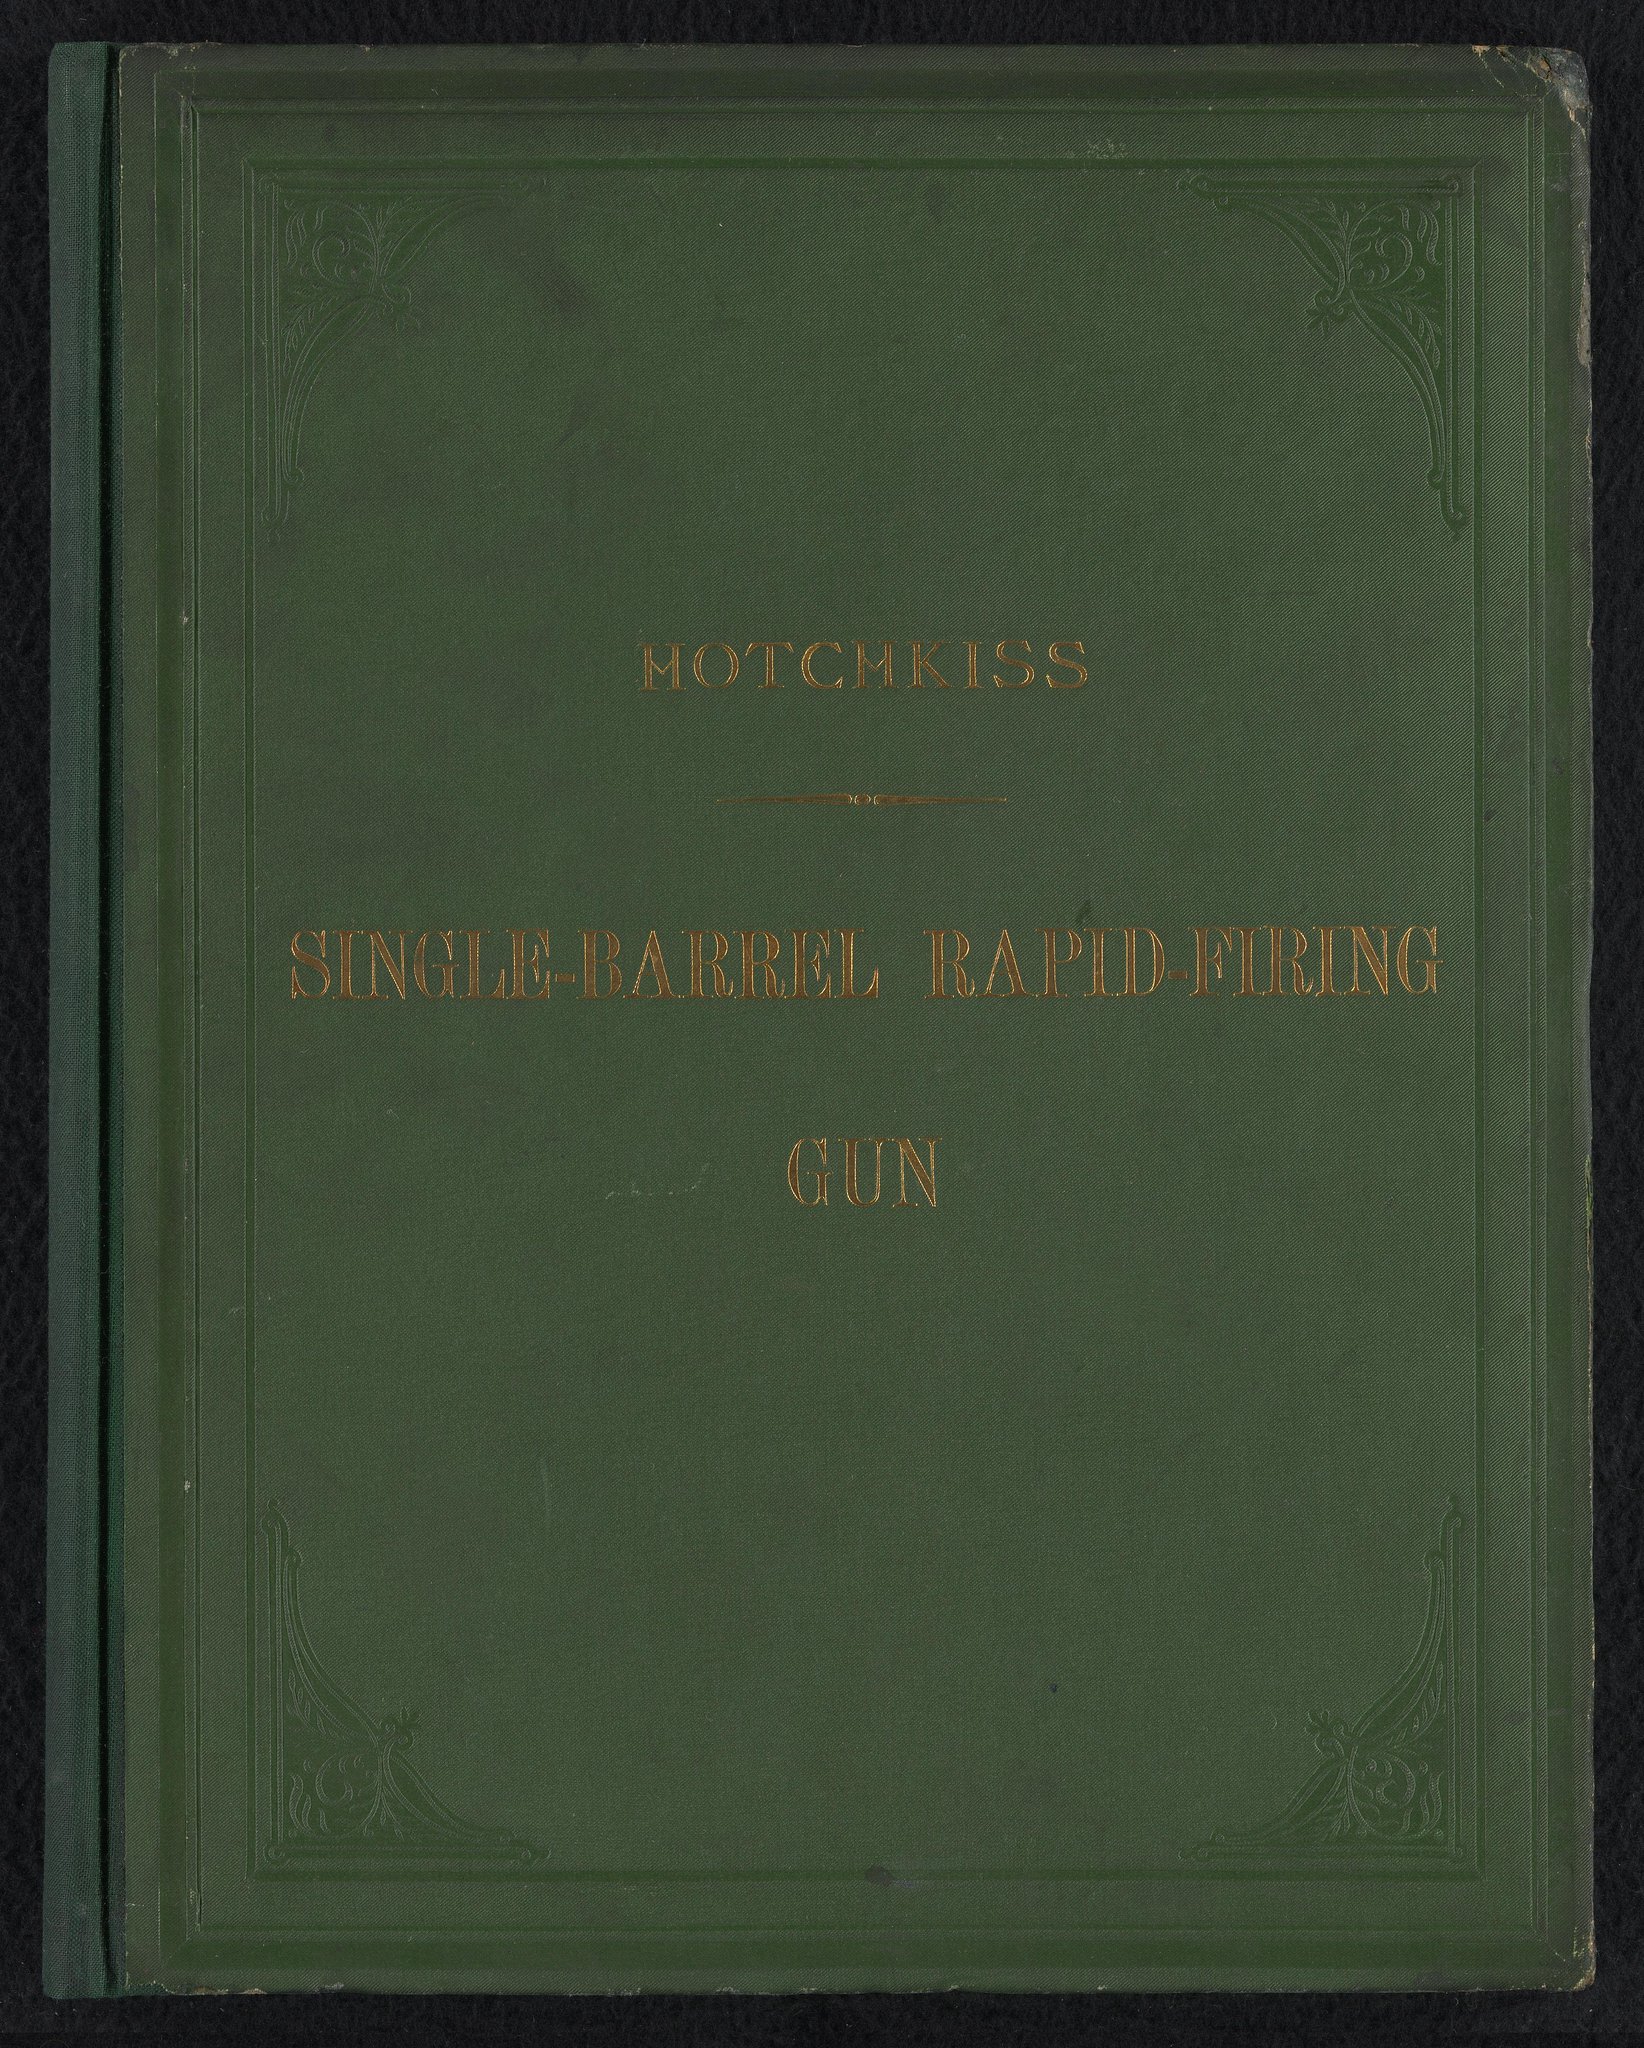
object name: book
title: The Hotchkiss Single-Barrel Rapid-Firing Gun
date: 1884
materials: cardboard, paper, textile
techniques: albumen print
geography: paris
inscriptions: inscription: ‘J1 19'98’, inscription: ‘$1000’, inscription: ‘Compliments of Hotchkiss [...]:’, inscription: ‘Jxxx/ Repair/ 8/2002/ #12018/ REAR/ PAGE/ JOI. = / TOTAL’, date: ‘FEB/ 2003’, inscription: ‘CARNEGIE/ Allegheny/ Pa./ Free Library’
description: Boek met 7 foto's van het Hotchkiss snelvuurkanon.